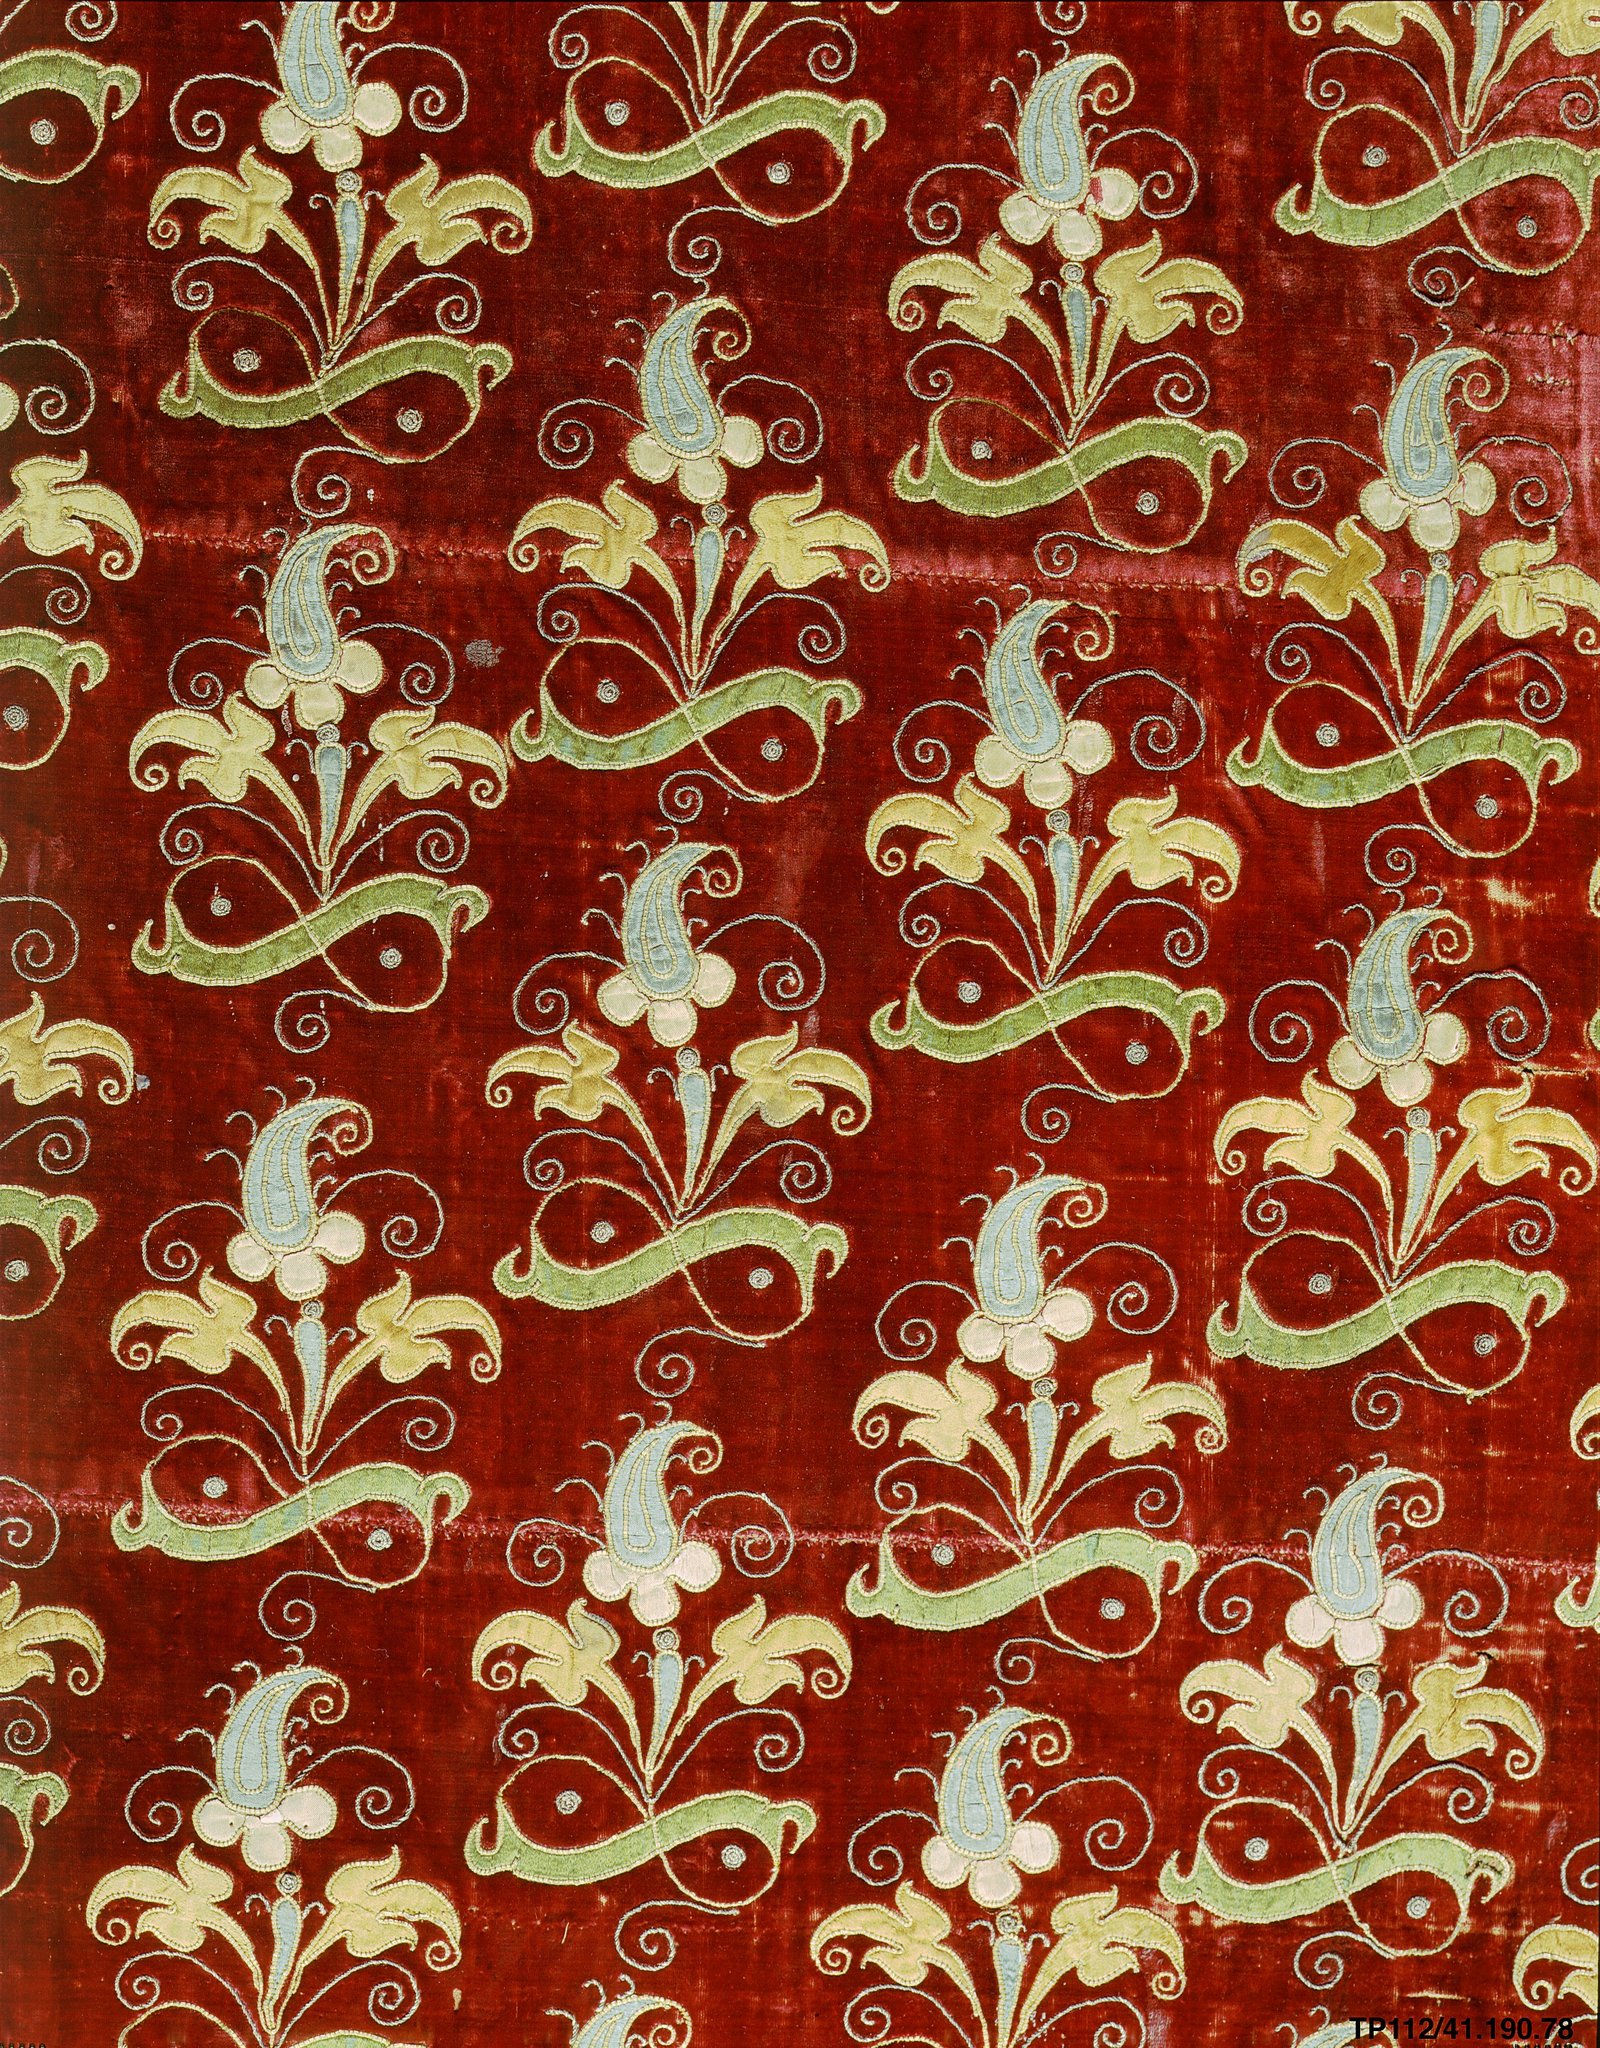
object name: runner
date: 1501-1600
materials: metal thread, silk